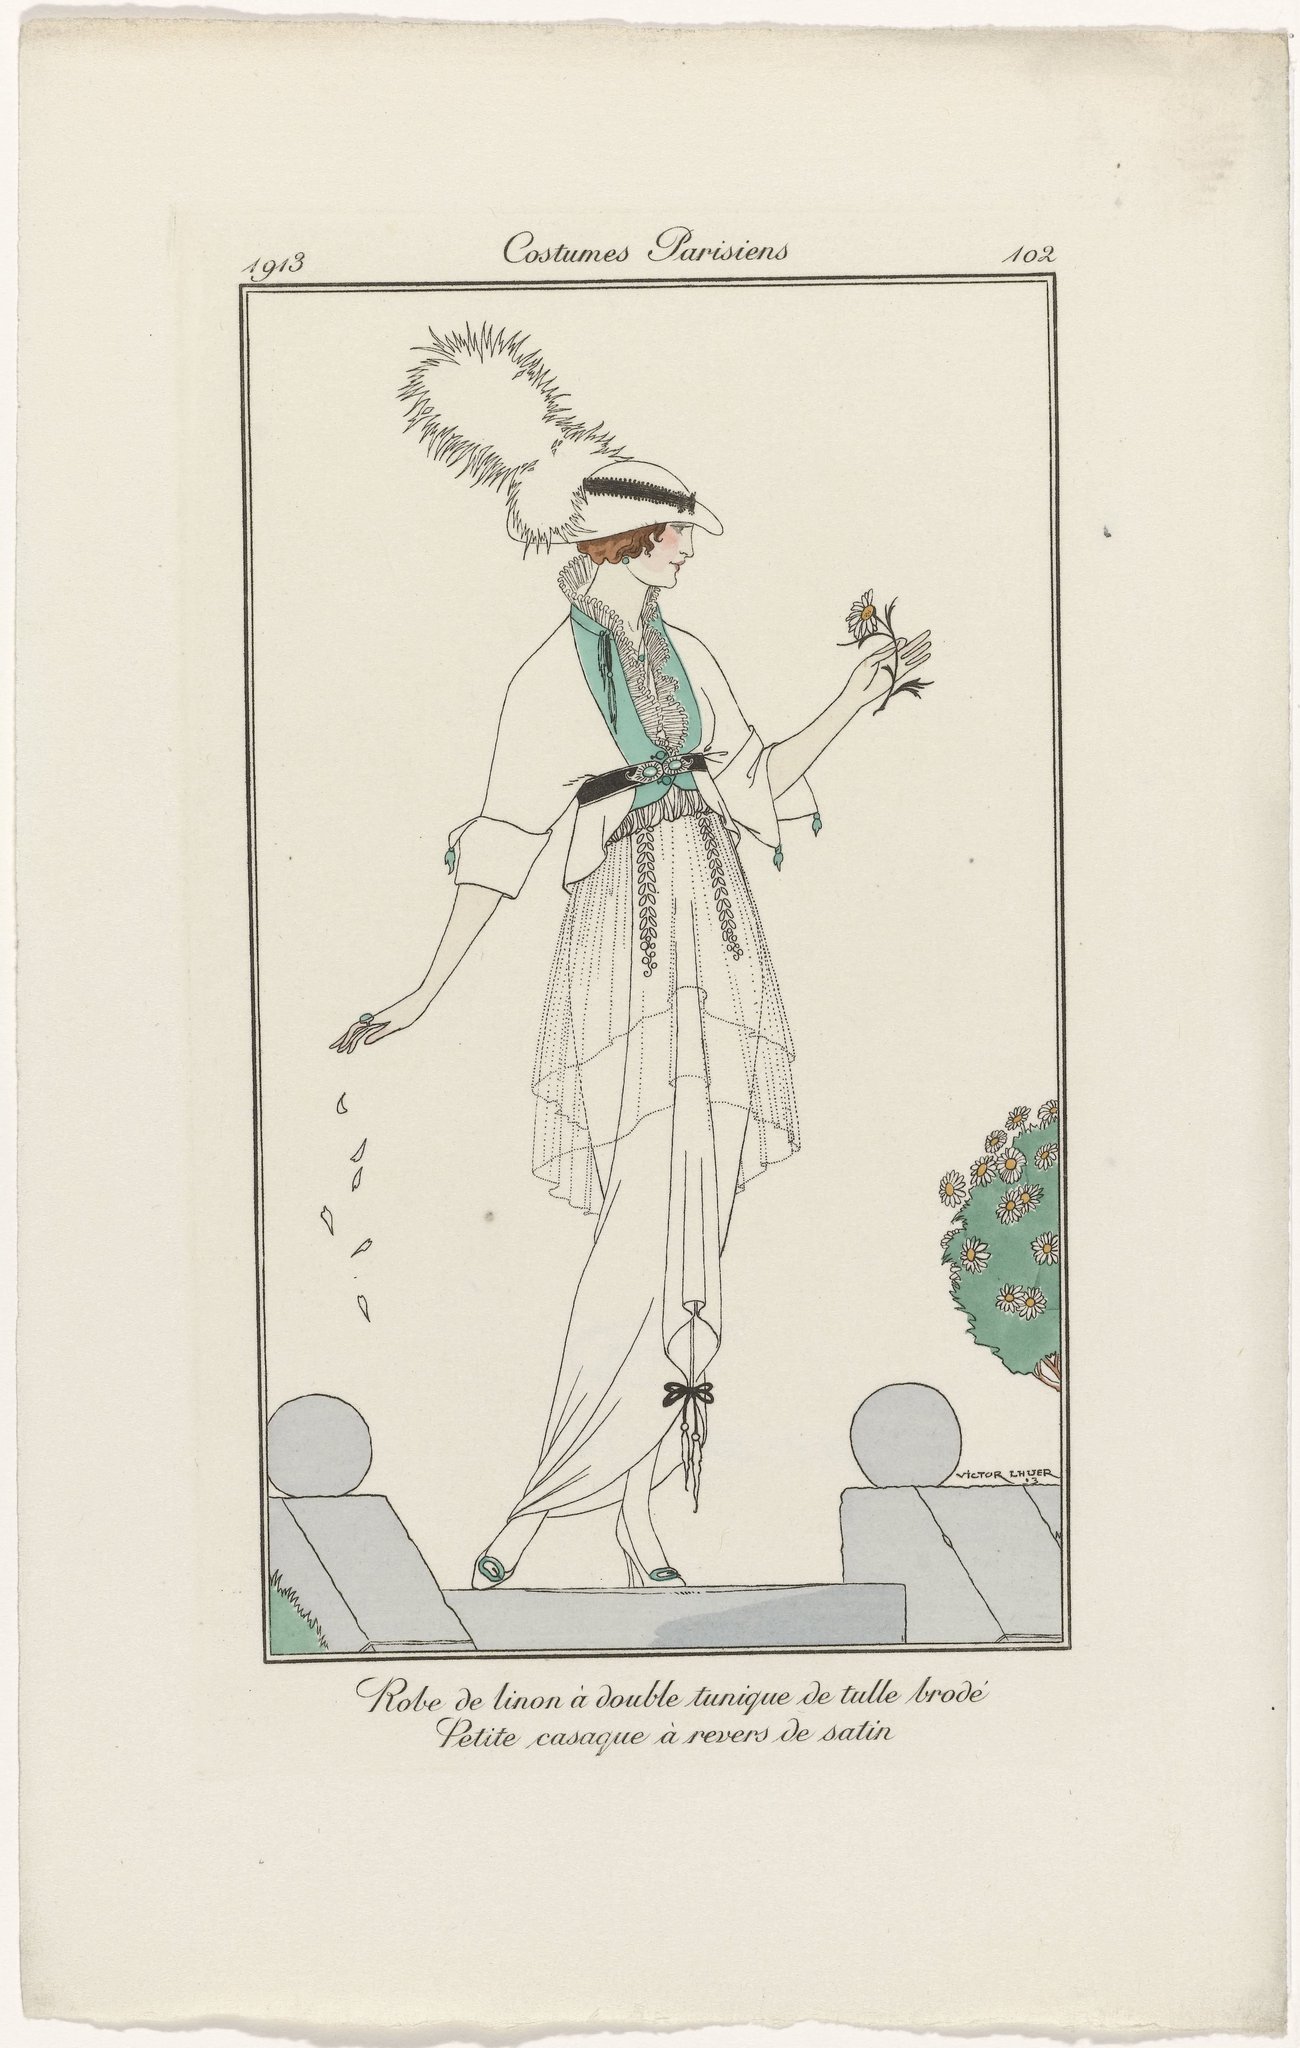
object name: fashion print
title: Journal des Dames et des Modes, Costumes Parisiens, 1913, No. 102 : Robe de linon (...)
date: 1913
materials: paper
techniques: engraving, hand coloring, pochoir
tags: neck-gear ~ clothing (revers) (+ women's clothes), embroidery (ornamentation) (+ women's clothes), clothing for the upper part of the body (tunic) (+ women's clothes), picking flowers (+ variant), coat (+ women's clothes), fashion plates, head-gear: hat (+ women's clothes), dress, gown (+ women's clothes)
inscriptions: title: ‘Costumes Parisiens’, caption: ‘Robe de linon à double tunique de tulle brodé Patite casaque à revers de satin.’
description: Japon van fijn linnen en dubbele tuniek van geborduurde tule. Kleine 'casaque' met revers van satijn. Prent uit het modetijdschrift Journal des Dames et des Modes (1912-1914).